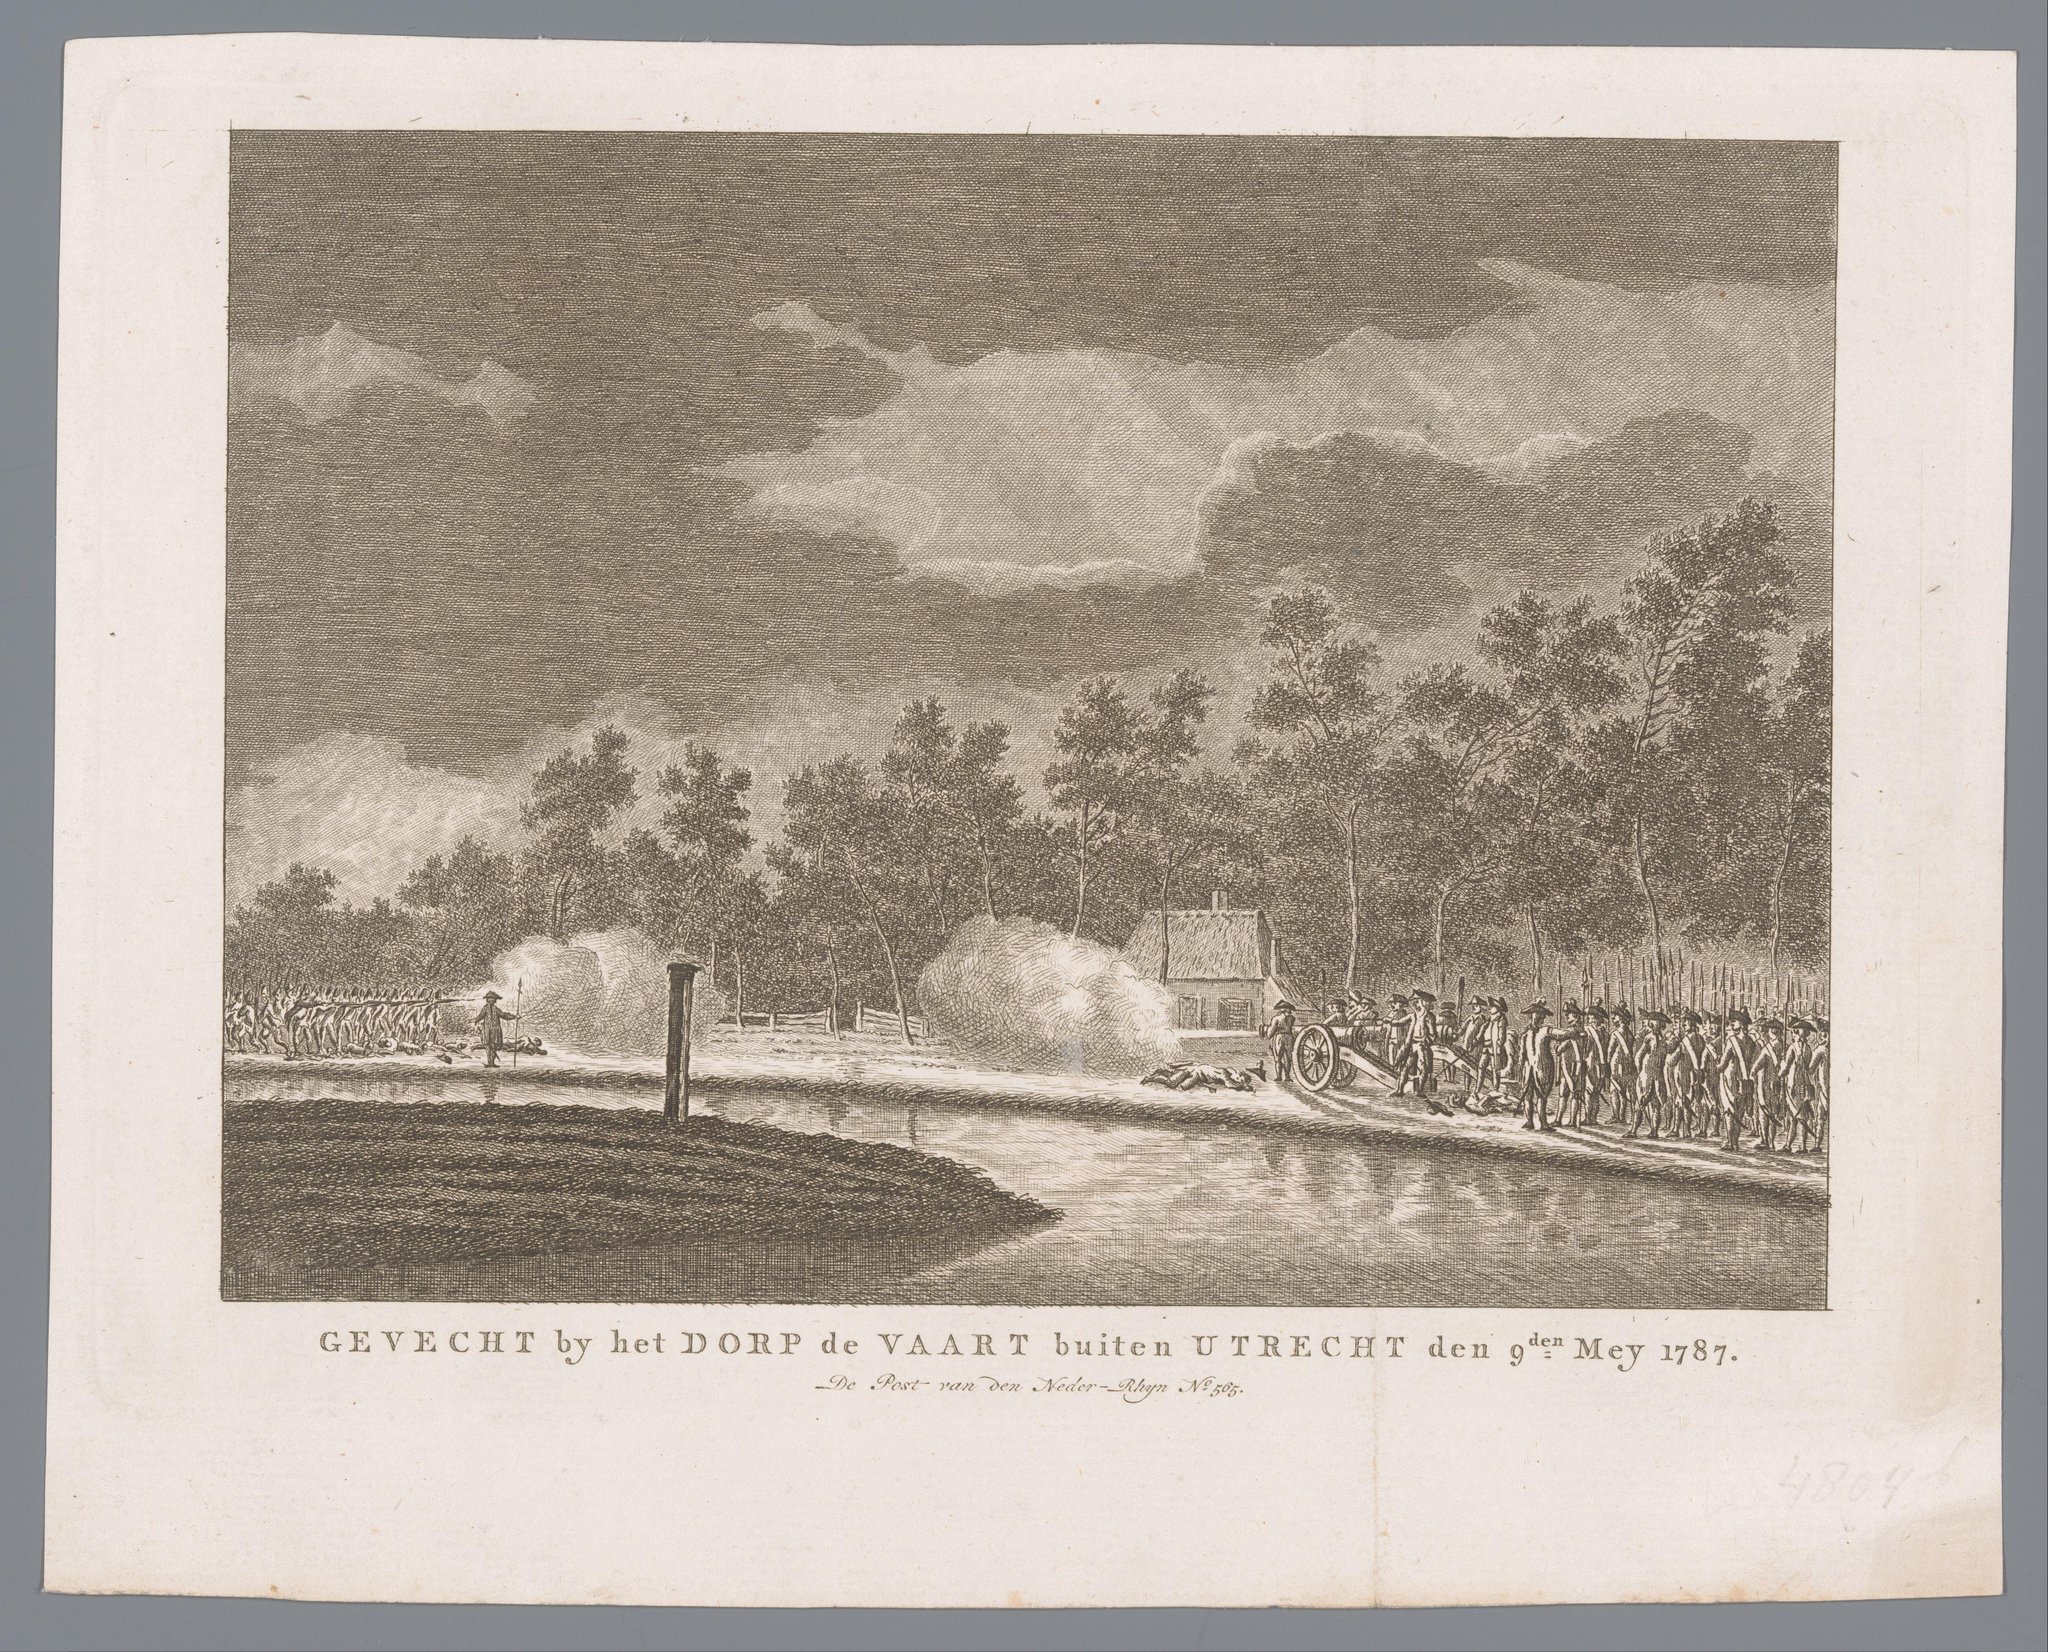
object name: print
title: Gevecht by het dorp de Vaart buiten Utrecht den 9den mey 1787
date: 1787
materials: paper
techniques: engraving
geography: utrecht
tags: battle (+ citizen soldiery, civil guard, citizen militia)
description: Prent uit: De Post van den Neder-Rhijn (1787), nr. 565.